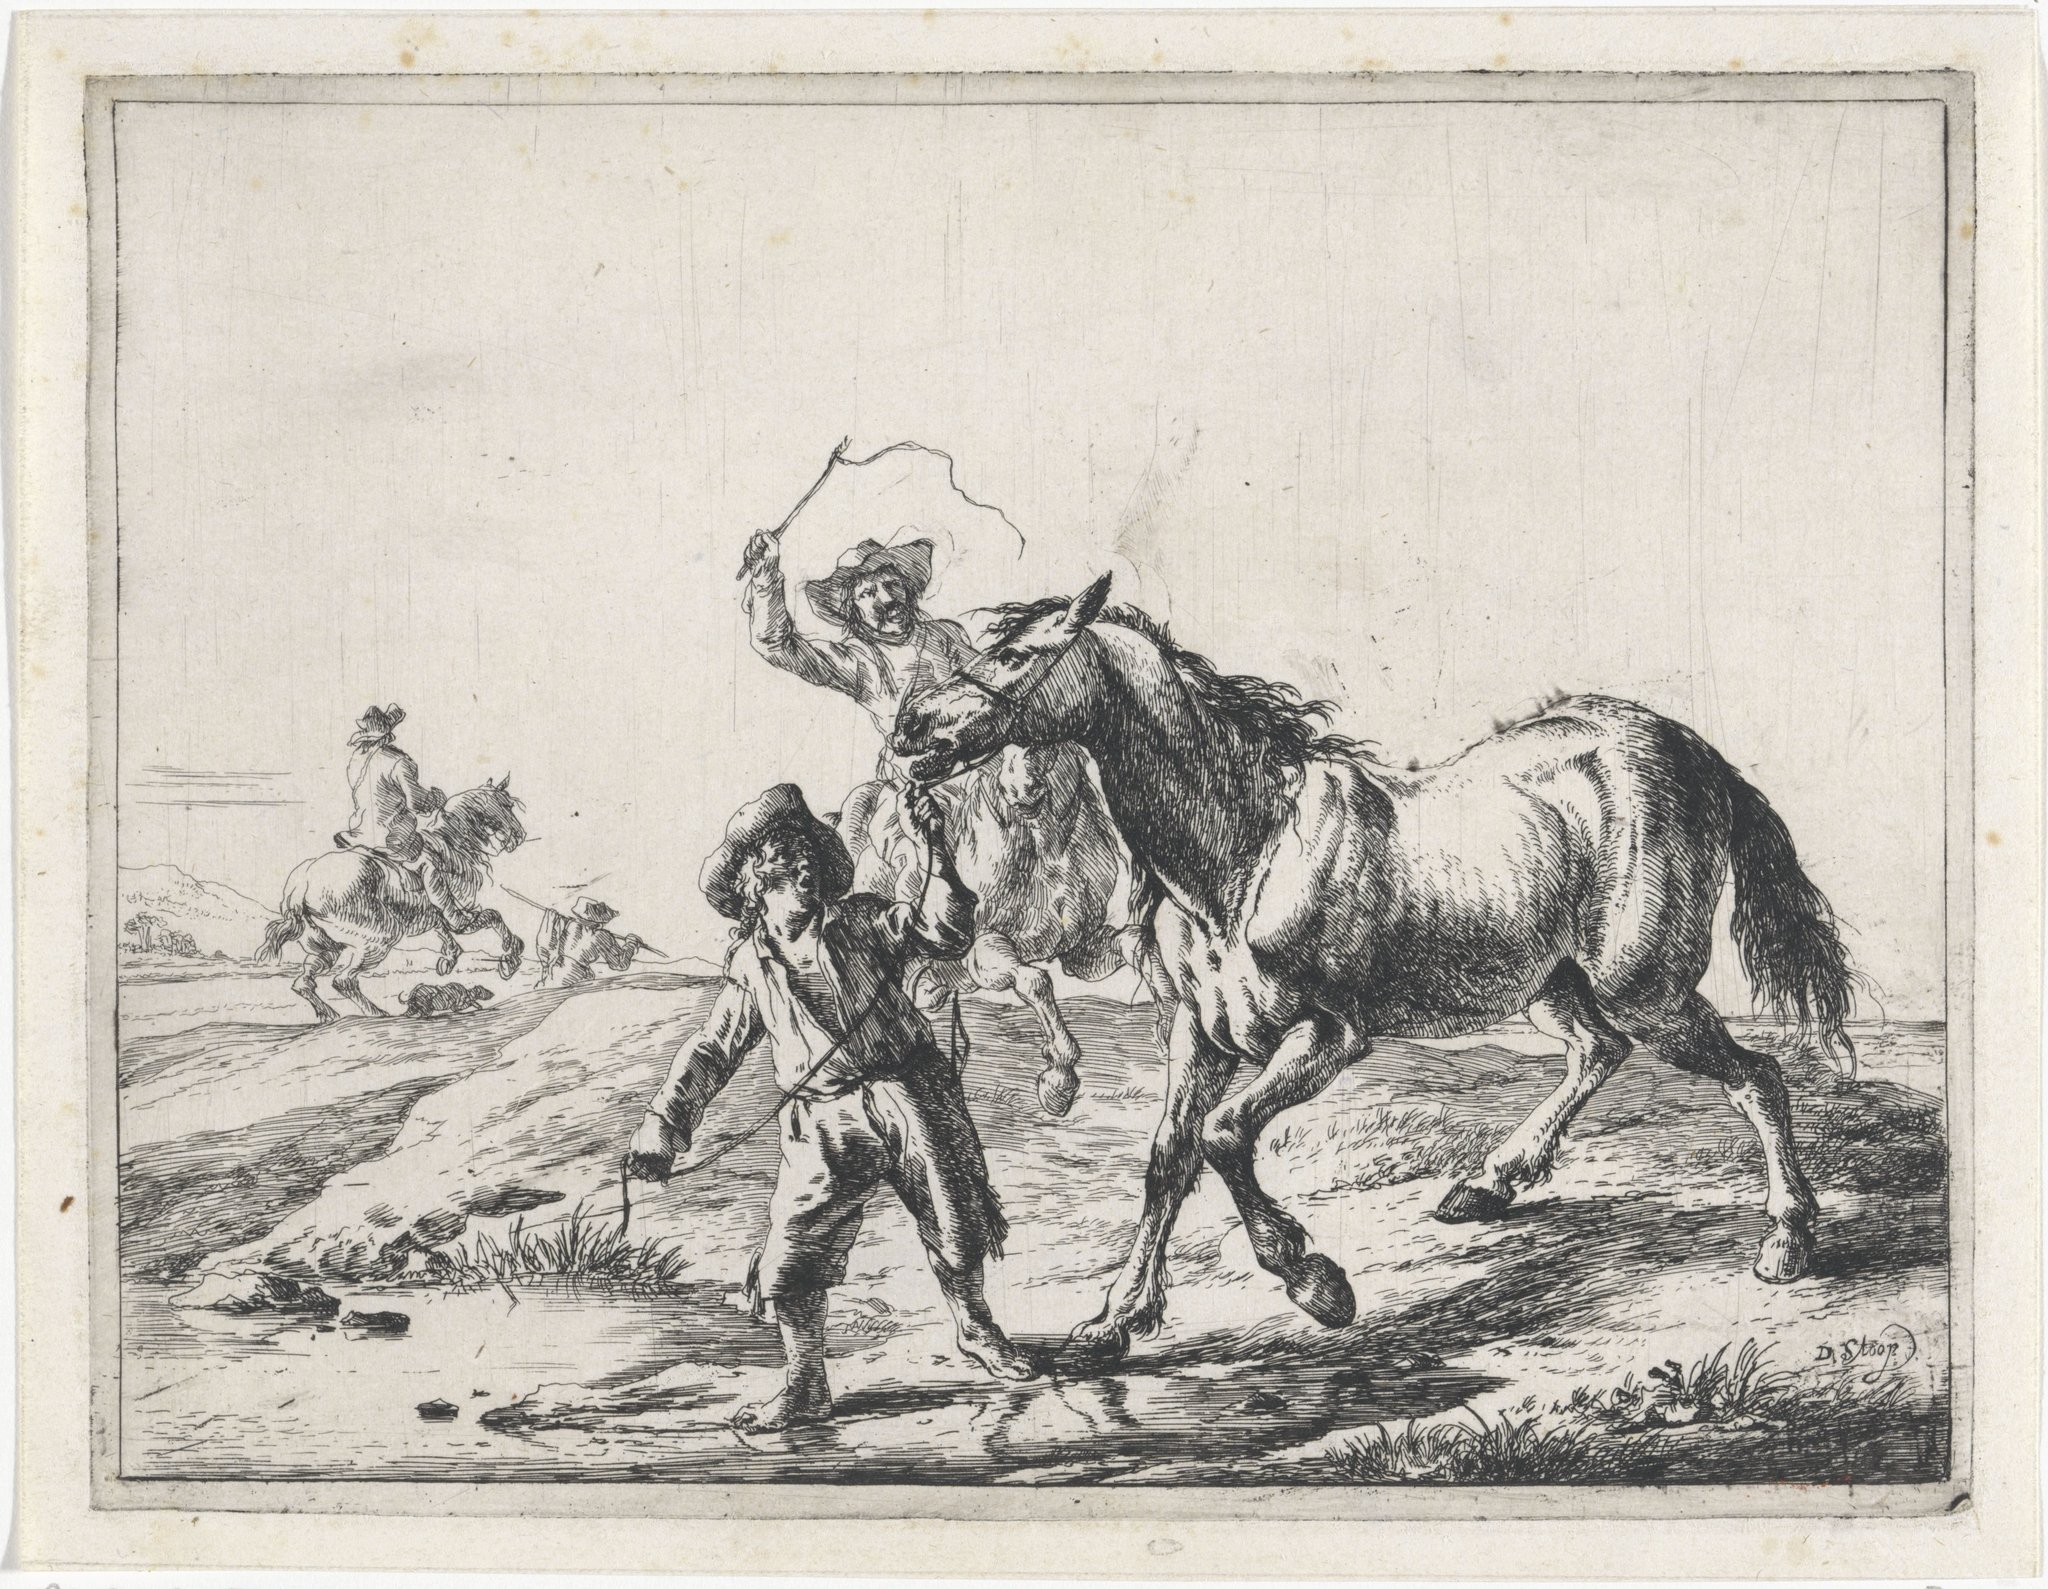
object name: print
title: Een jongen leidt een paard naar het water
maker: dirk stoop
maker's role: draughtsman, painter, print maker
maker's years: 1615-1686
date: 1651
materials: paper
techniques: etching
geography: utrecht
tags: horse (+ animals eating and drinking)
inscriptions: collector's mark: Lugt 2228, collector's mark: Lugt 240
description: Een jongen leidt een paard naar het water om het te laten drinken. Op de achtergrond ruiters.